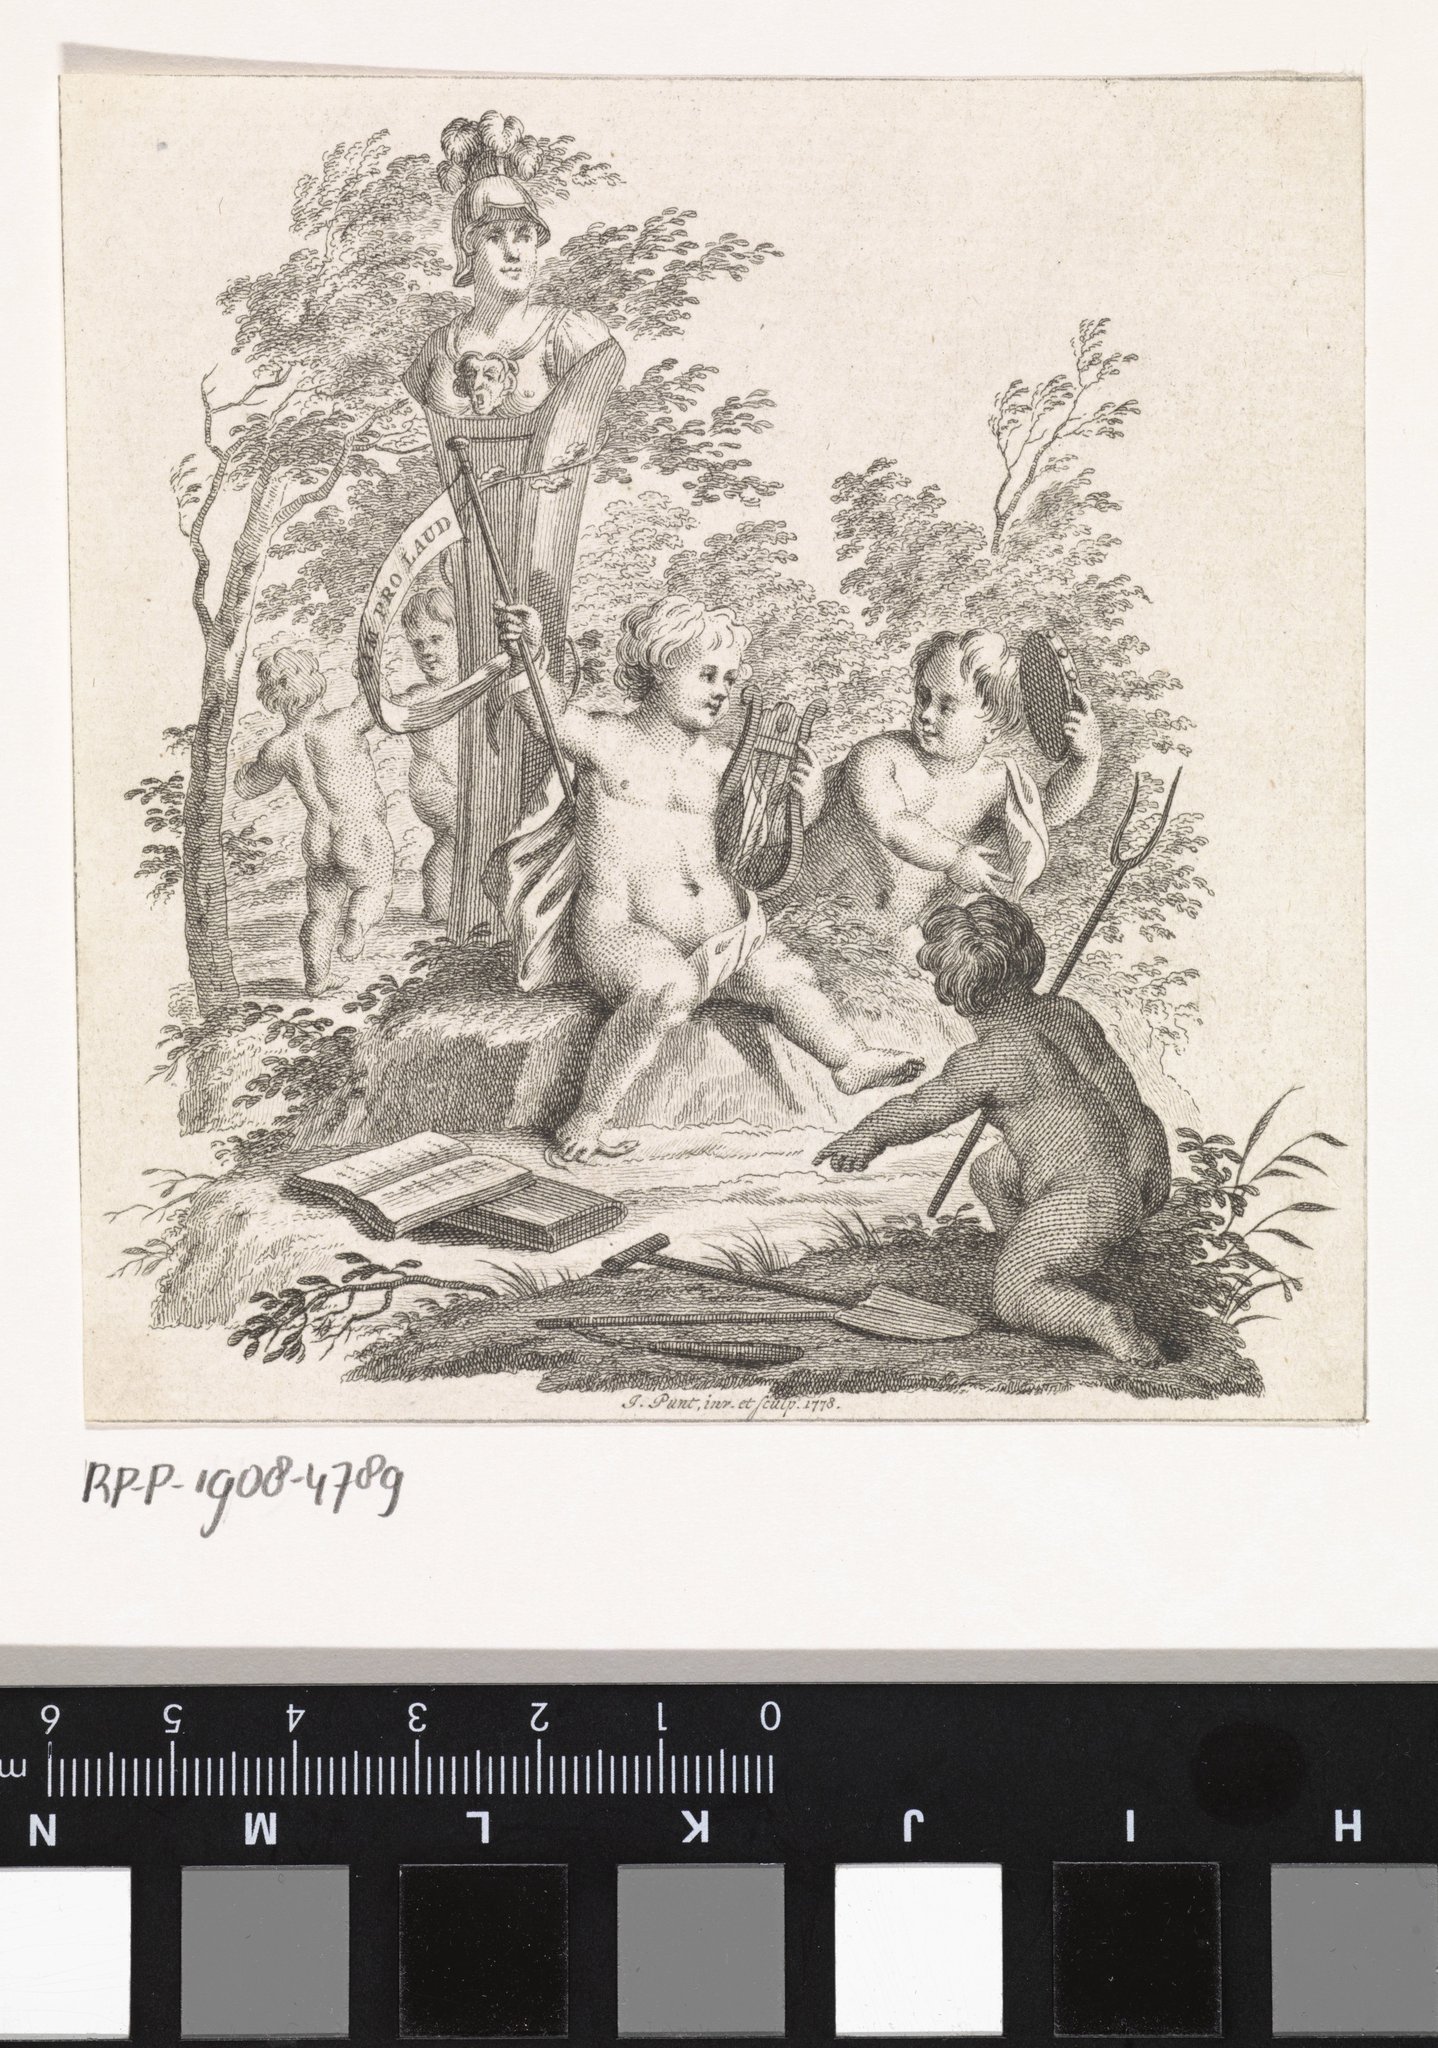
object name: print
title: Landschap met putti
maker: jan punt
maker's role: draughtsman, print maker, publisher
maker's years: 1711-1779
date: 1778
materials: paper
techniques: engraving, etching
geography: amsterdam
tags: herms (garden ornaments), dancing, making music; musician with instrument - cc - out of doors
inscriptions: collector's mark: Lugt 2228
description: Putti bij een herm in een landschap. Twee van hen spelen muziek, twee anderen dansen. Op de voorgrond een putto met een hark die wijst op een opengeslagen boek.